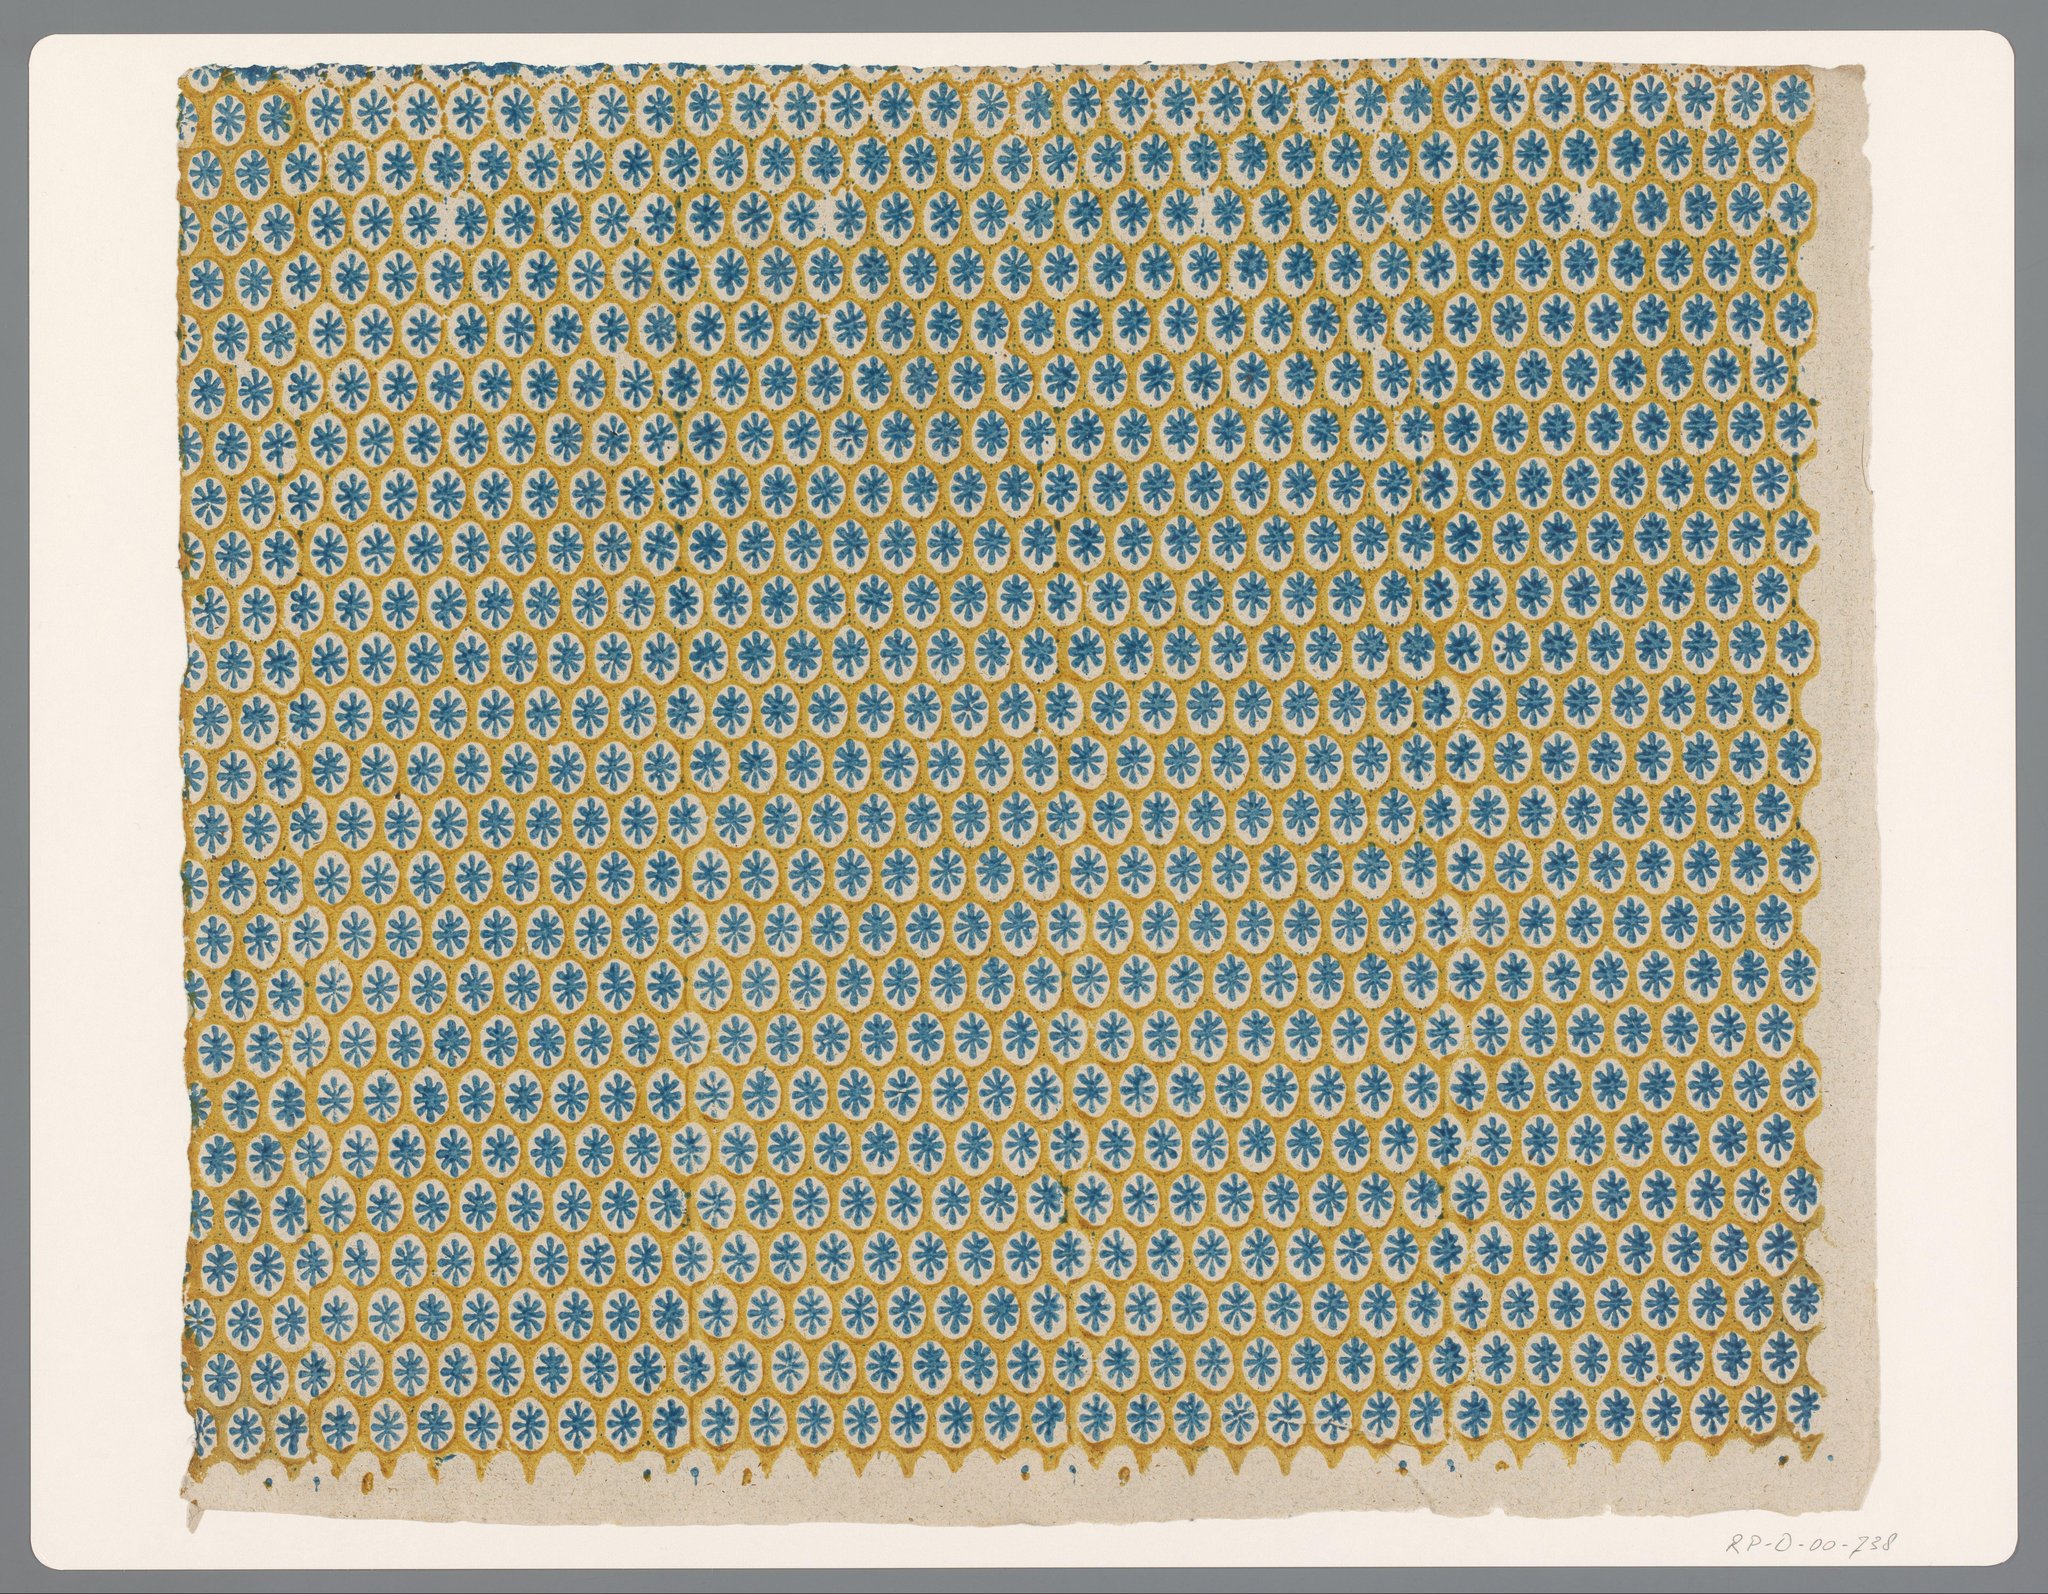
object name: printed paper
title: Blad met strooipatroon van bloemmotief in uitgespaard ovaal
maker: Anonymous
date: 1750-1900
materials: paper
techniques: printing block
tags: ornament derived from plant forms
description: Blad met strooipatroon van bloemmotief in uitgespaard ovaal.